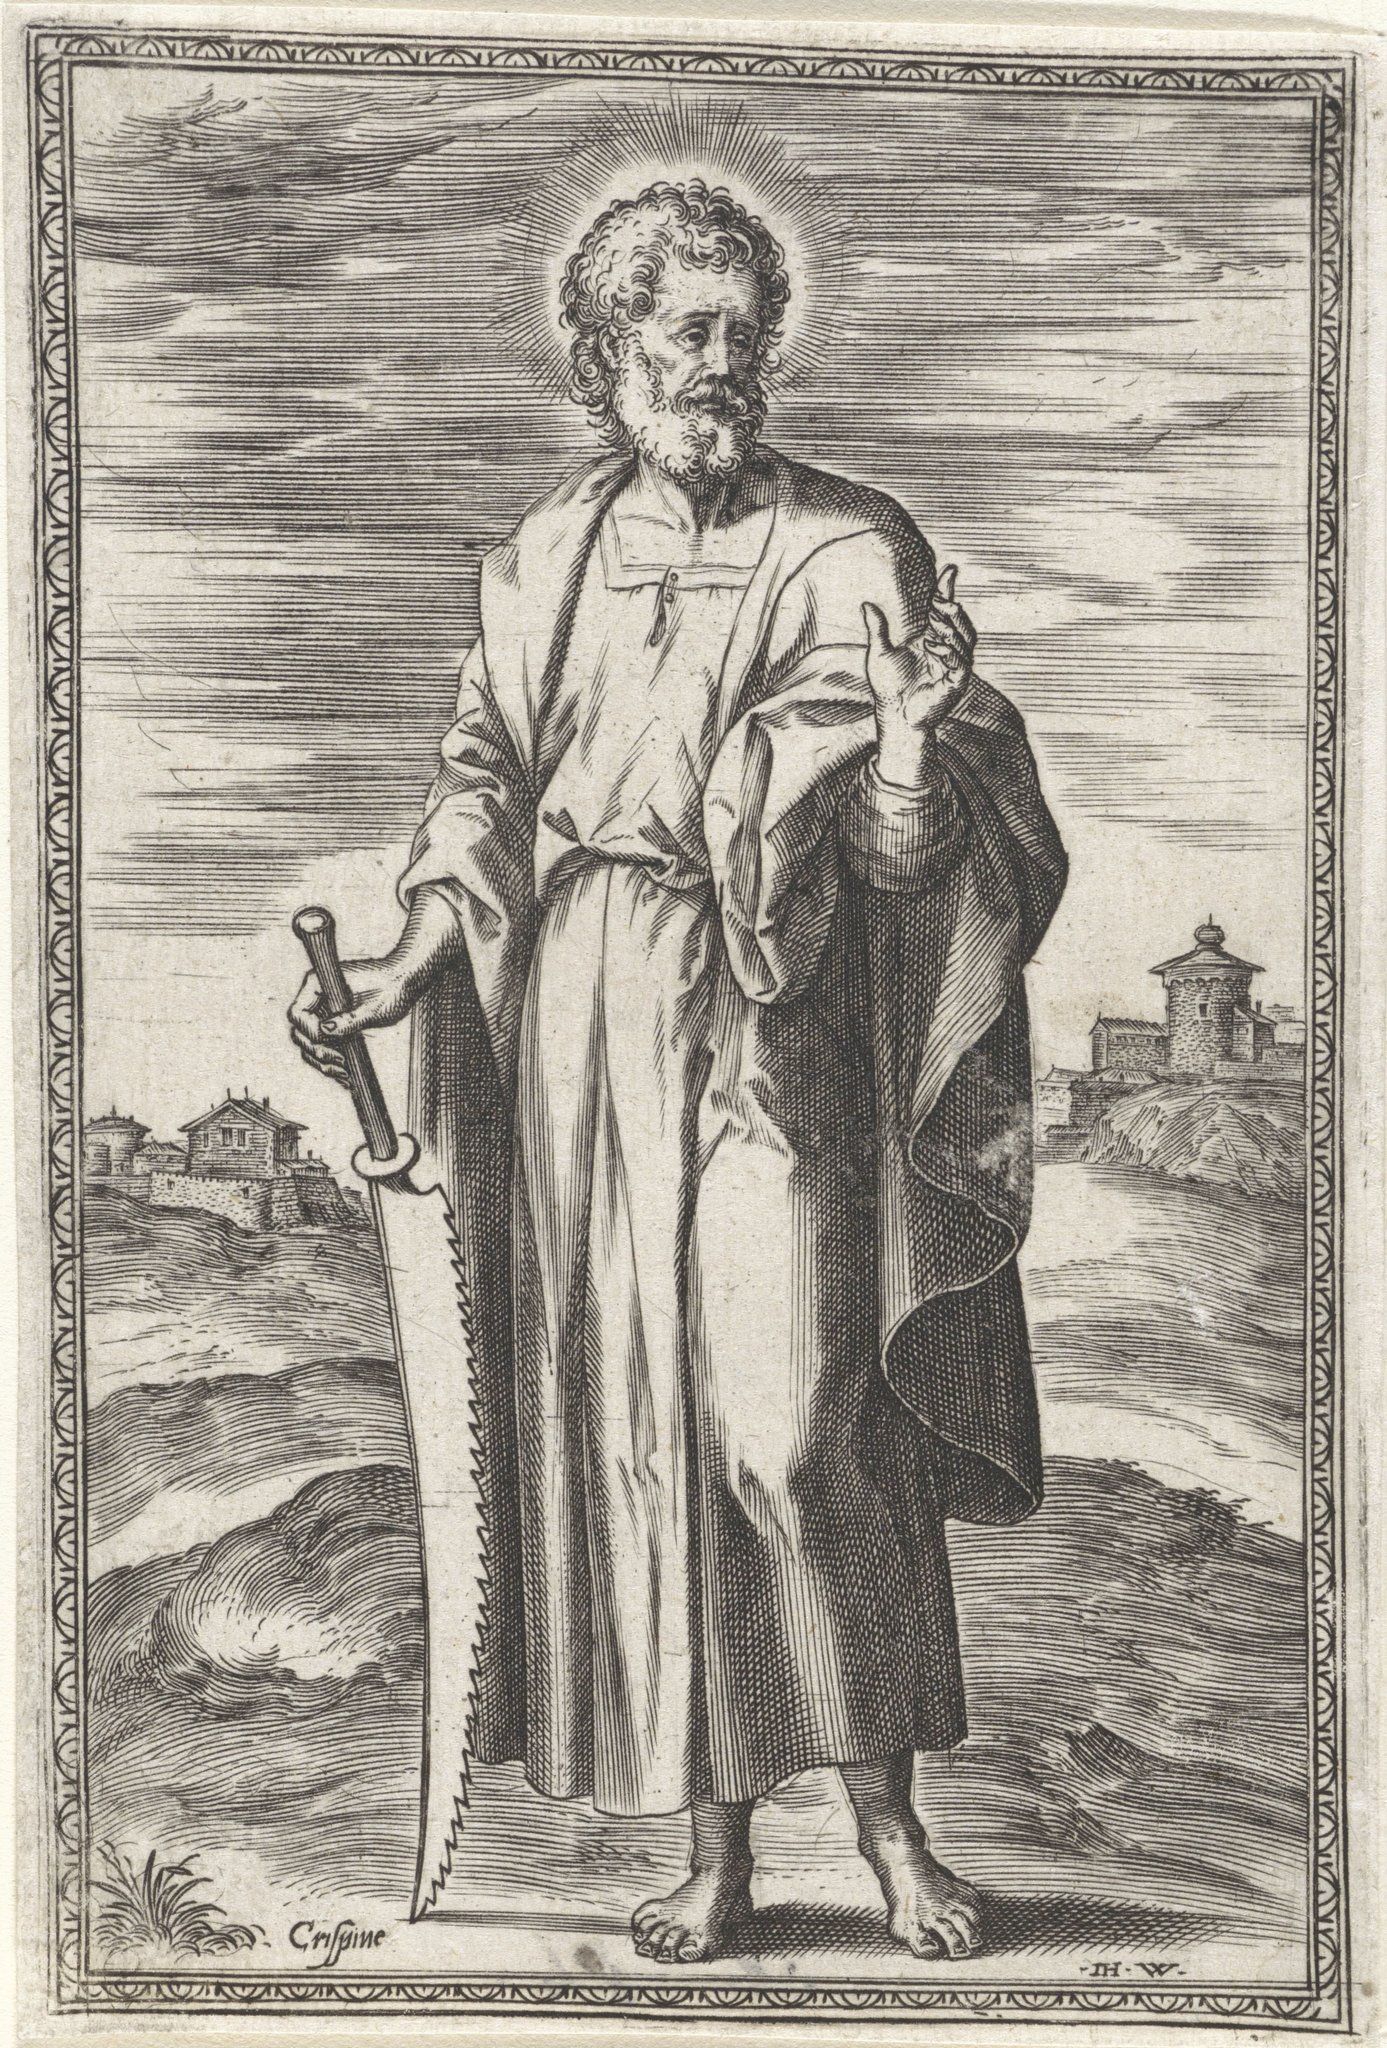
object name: print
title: H. Simon Zelotes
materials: paper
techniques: engraving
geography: antwerp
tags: the apostle simon zelotes (or simon the canaanite); possible attributes: book, saw, scroll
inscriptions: collector's mark: Lugt 2228, number: ‘38. - 84.’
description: Landschap met de apostel Simon Zelotes. In zijn ene hand houdt hij een zaag, met zijn andere hand maakt hij een gebaar.